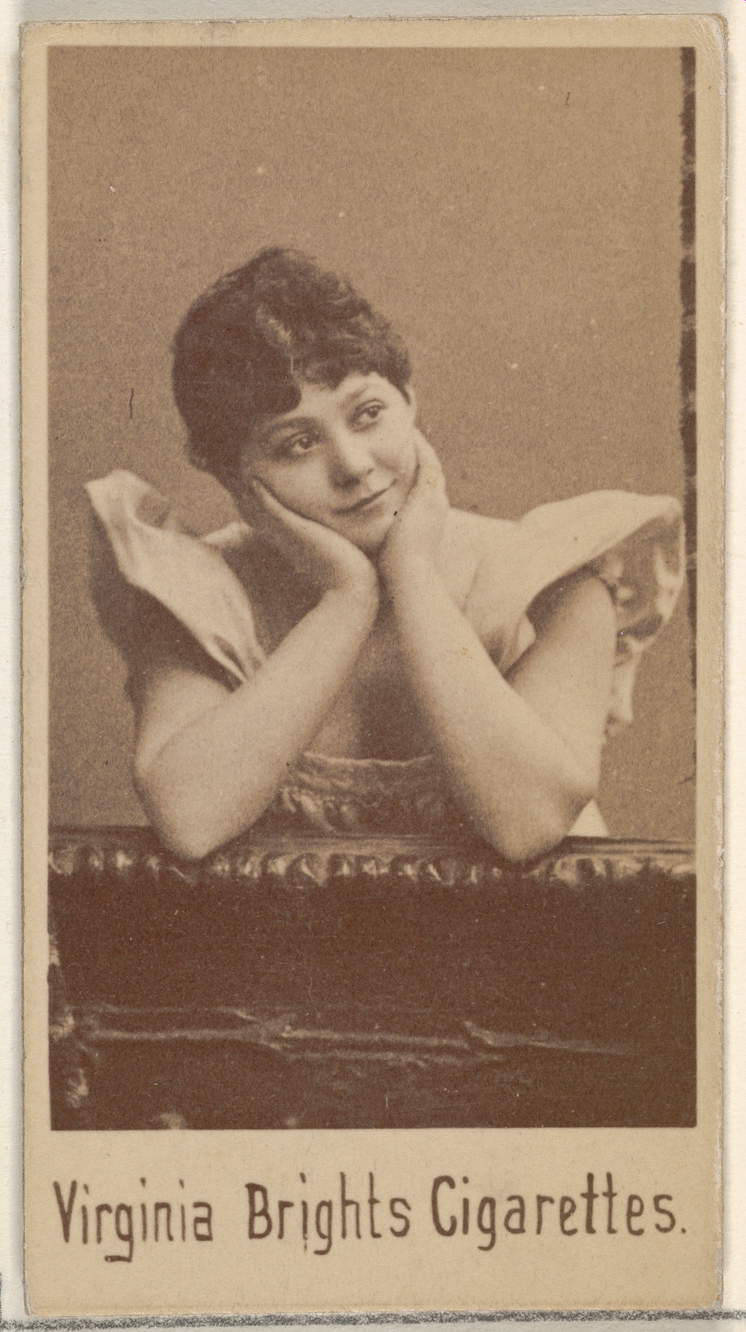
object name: photograph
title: From the Actors and Actresses series (N45, Type 5) for Virginia Brights Cigarettes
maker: allen & ginter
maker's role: publisher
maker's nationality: american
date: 1888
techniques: albumen silver print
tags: portraits,women,actresses